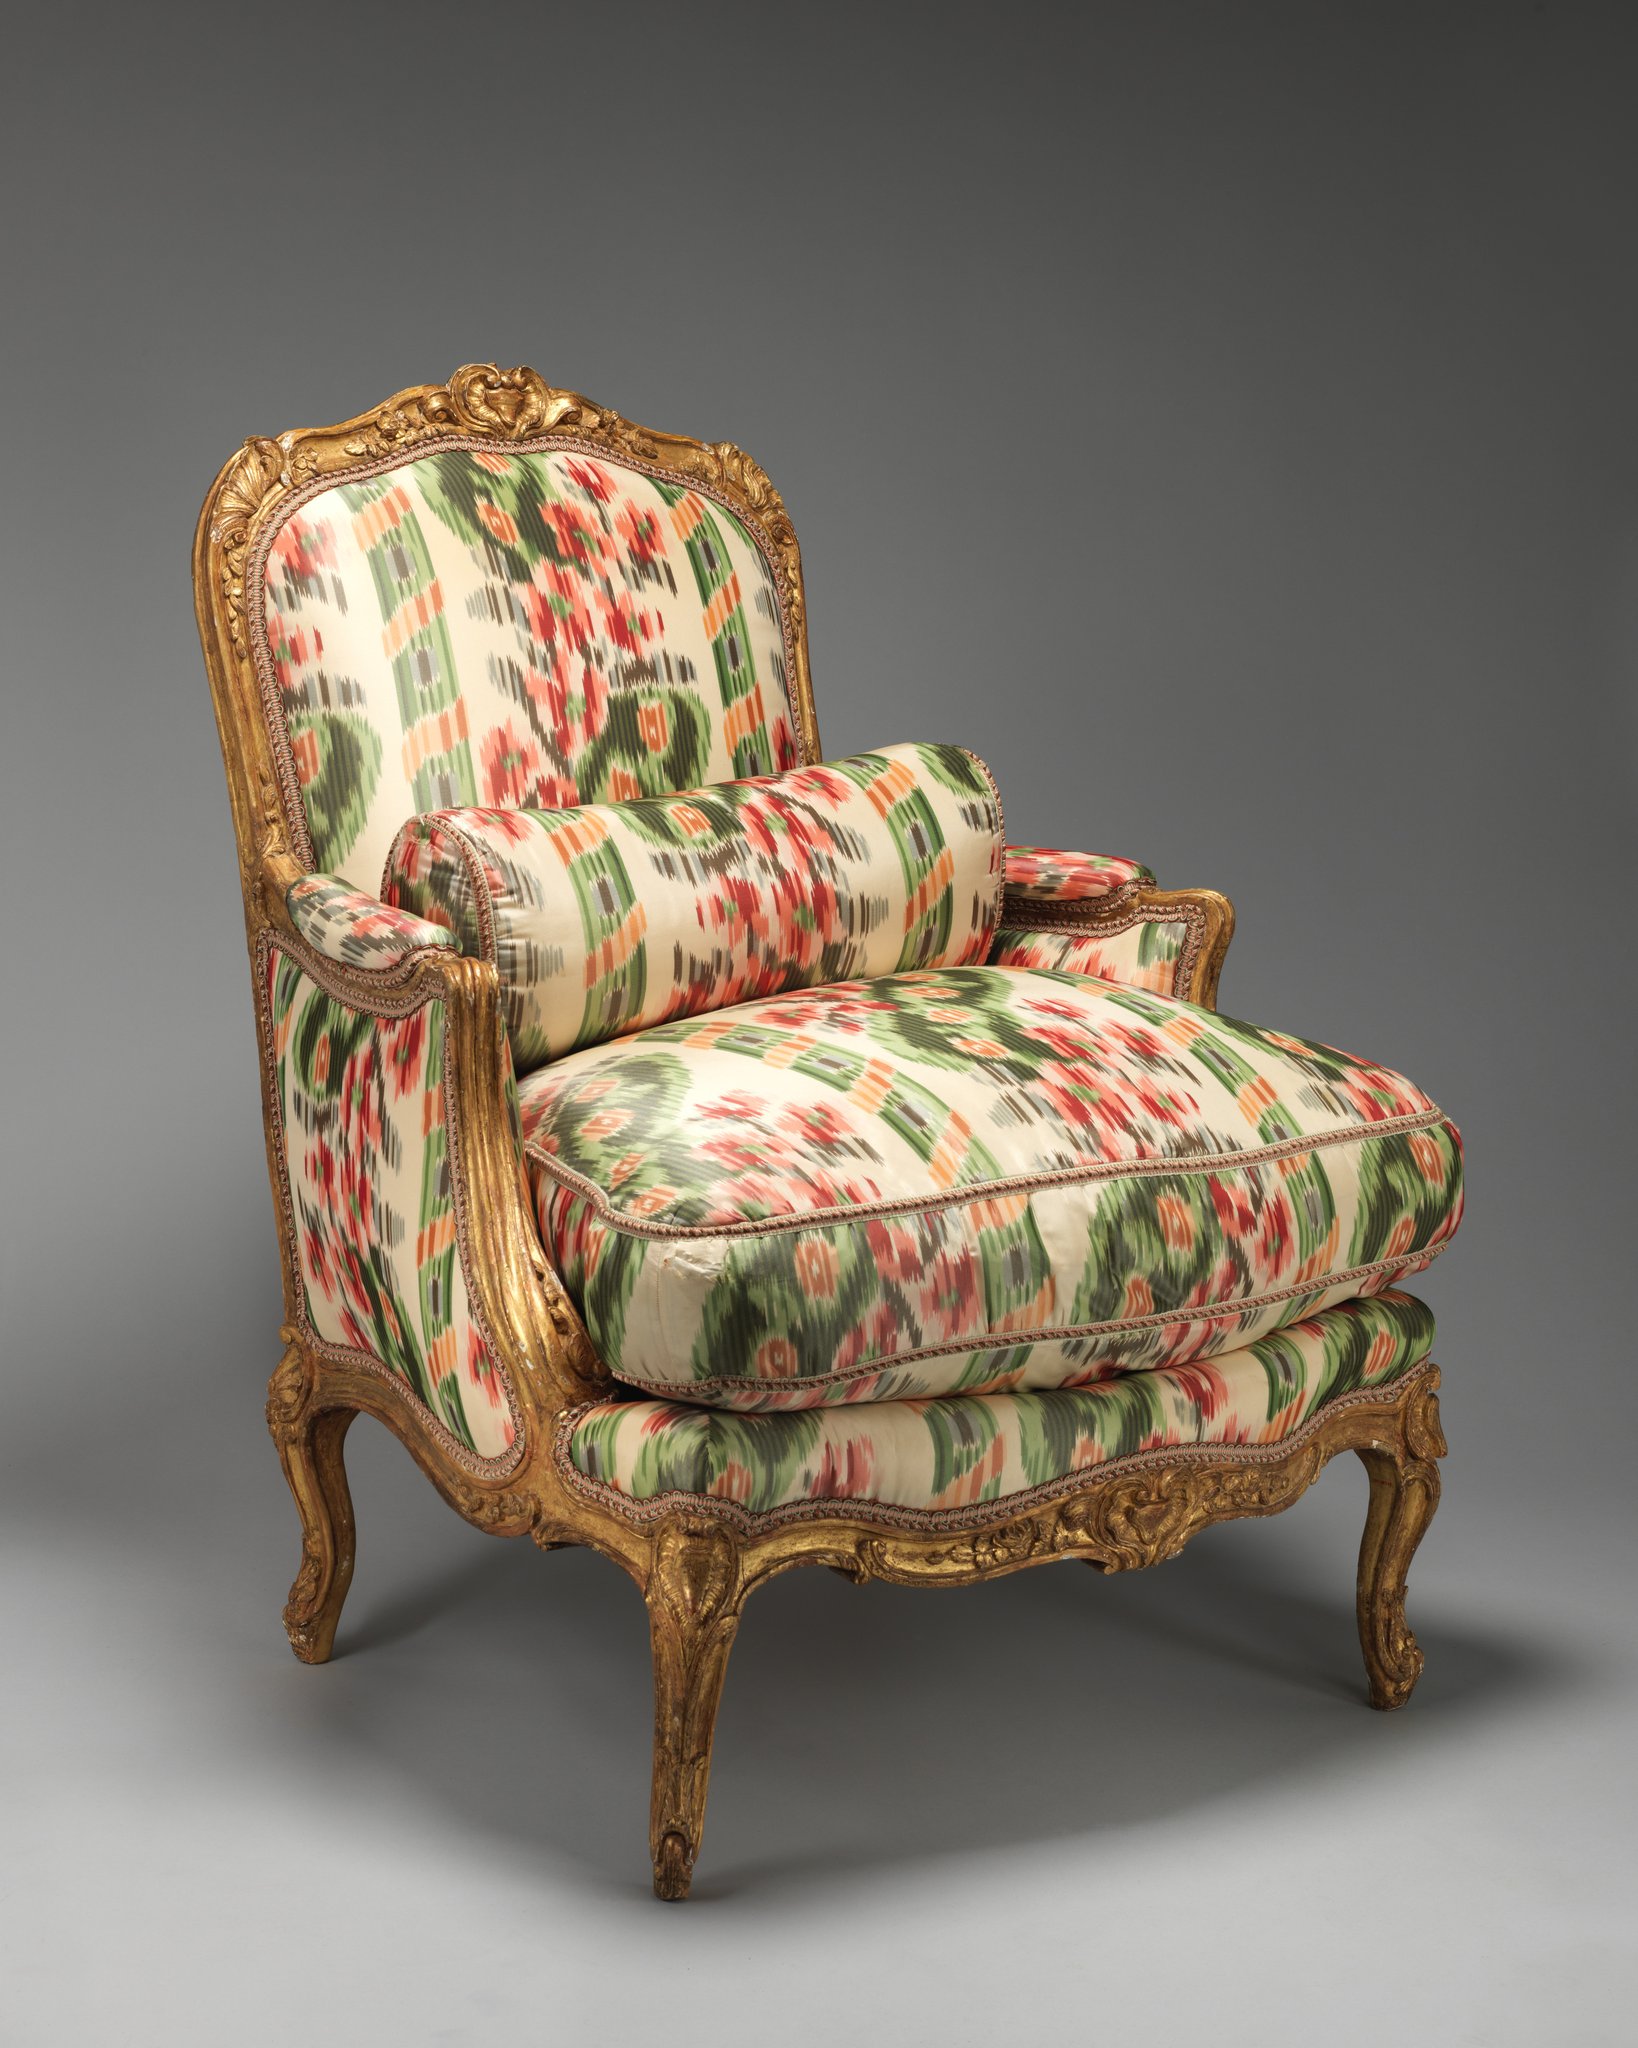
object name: armchair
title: Armchair (bergère à la Reine) (one of a pair)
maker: jean-baptiste i tilliard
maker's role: maker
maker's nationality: french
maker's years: 1686-1766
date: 1701-1800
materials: wood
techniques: carving, gilding